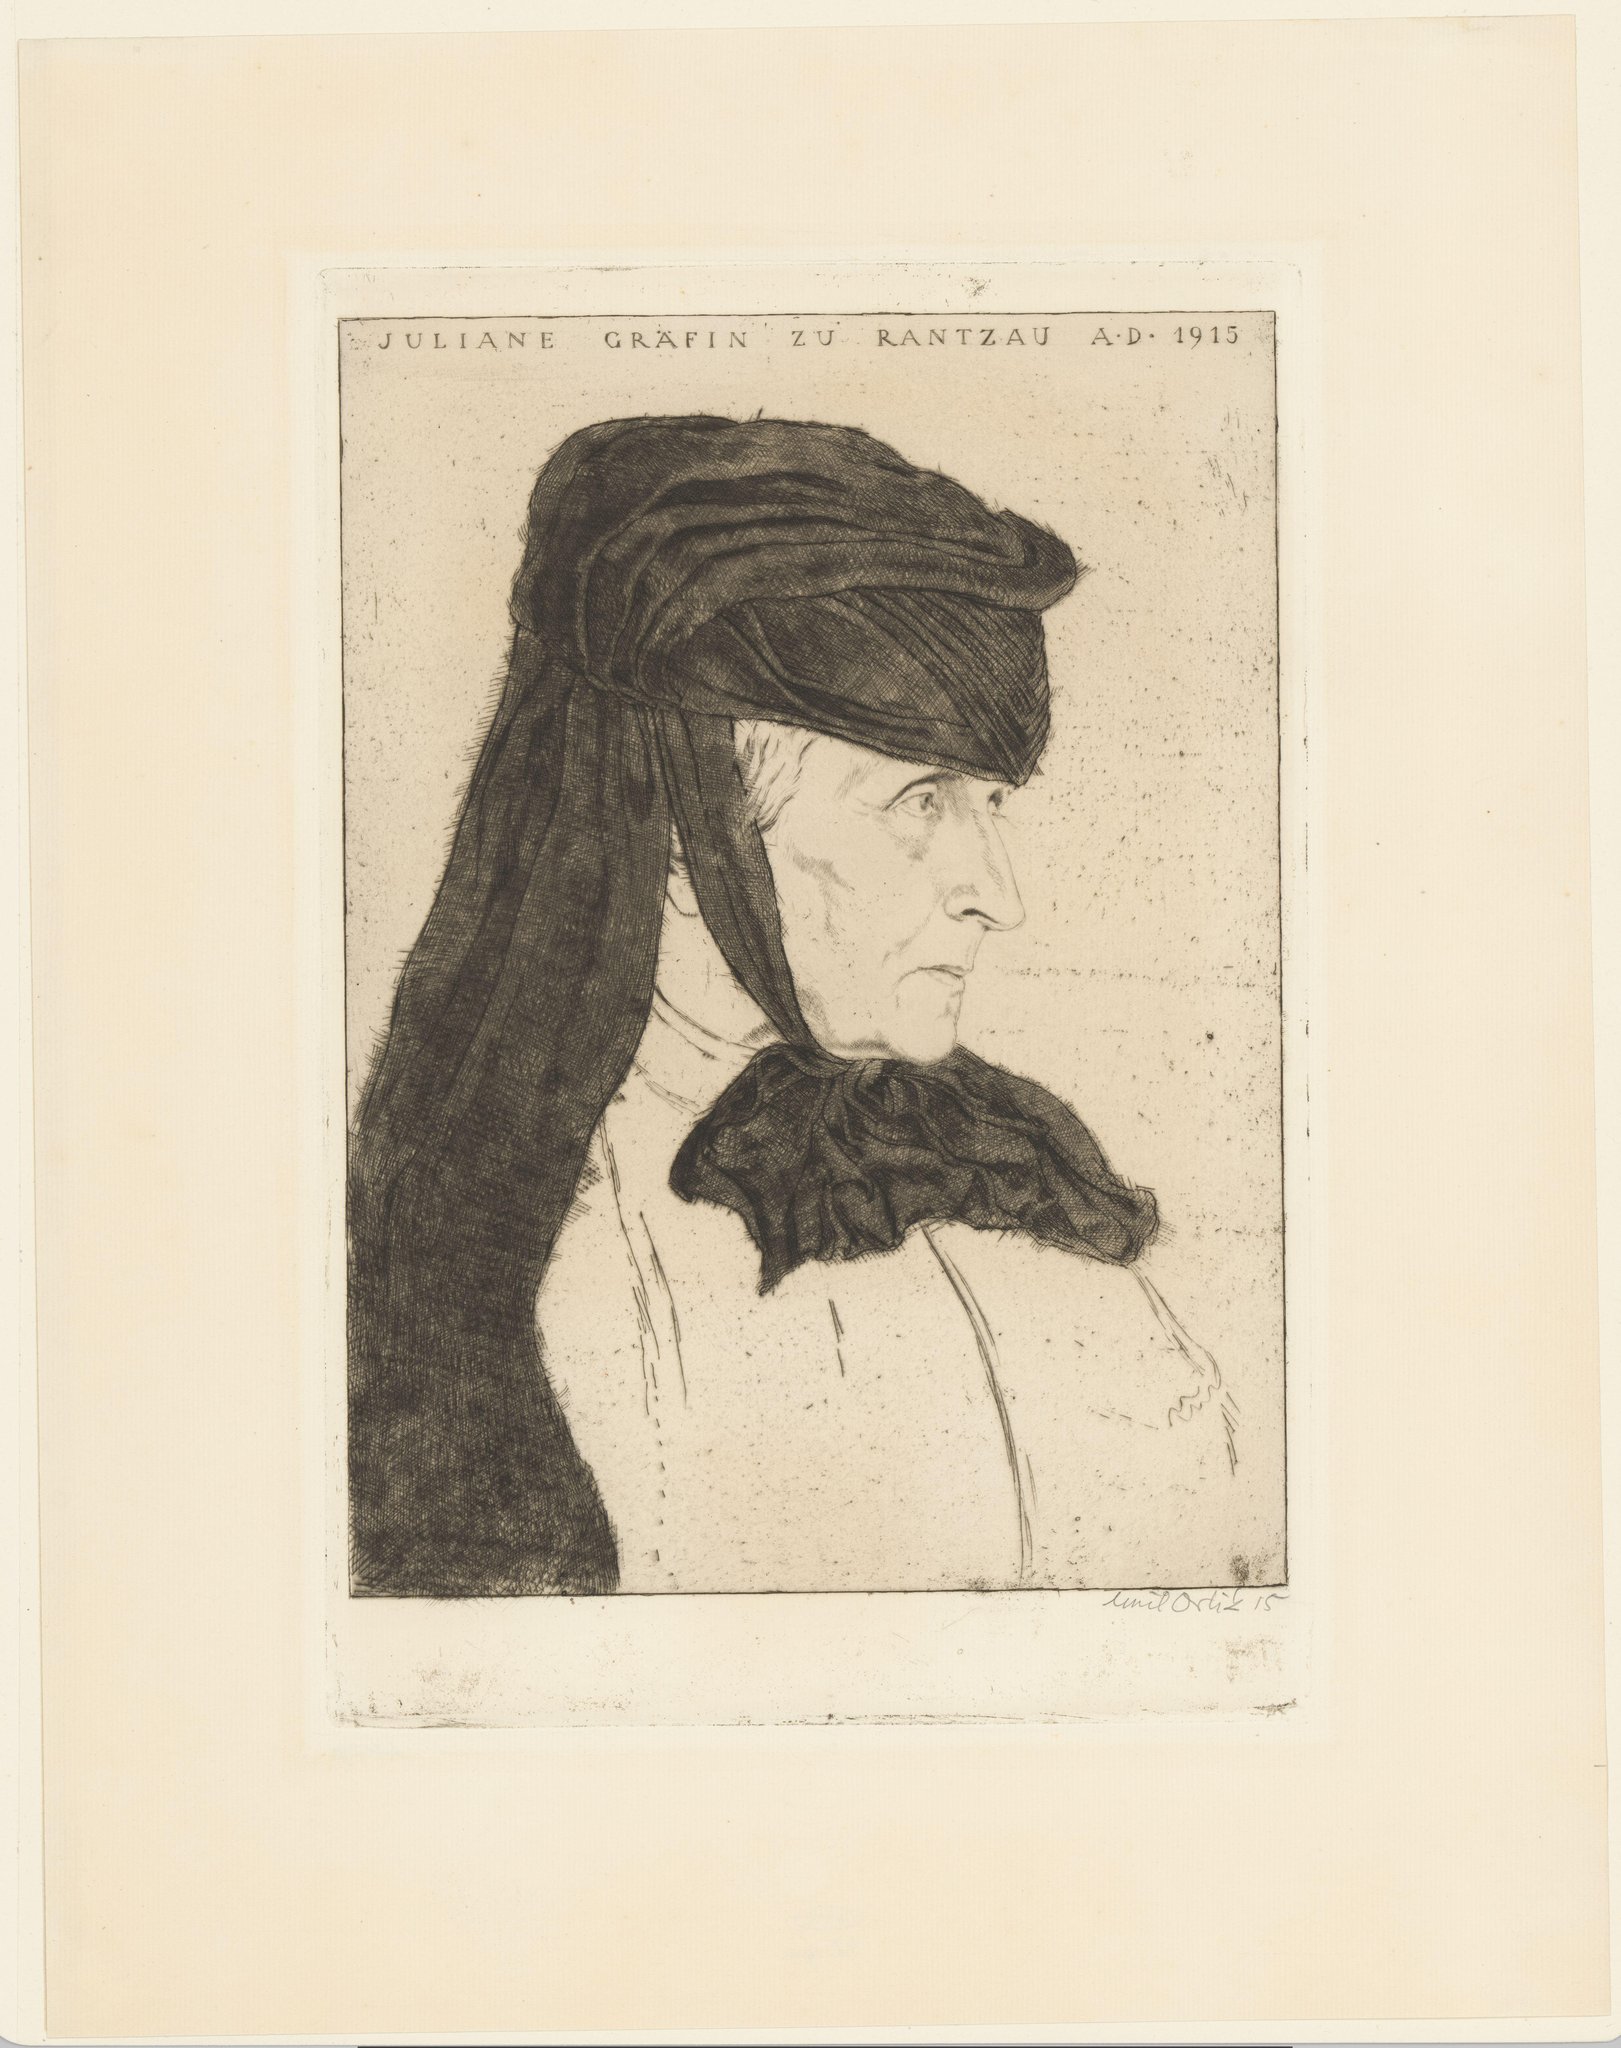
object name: print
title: Portret van Juliane zu Rantzau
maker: emil orlik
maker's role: painter, print maker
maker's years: 1870-1932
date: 1880-1932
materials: paper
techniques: drypoint, intaglio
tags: historical persons - bb - woman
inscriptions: name: ‘Emil Orlik 15’, collector's mark: Lugt 2228, collector's mark: Lugt 2760